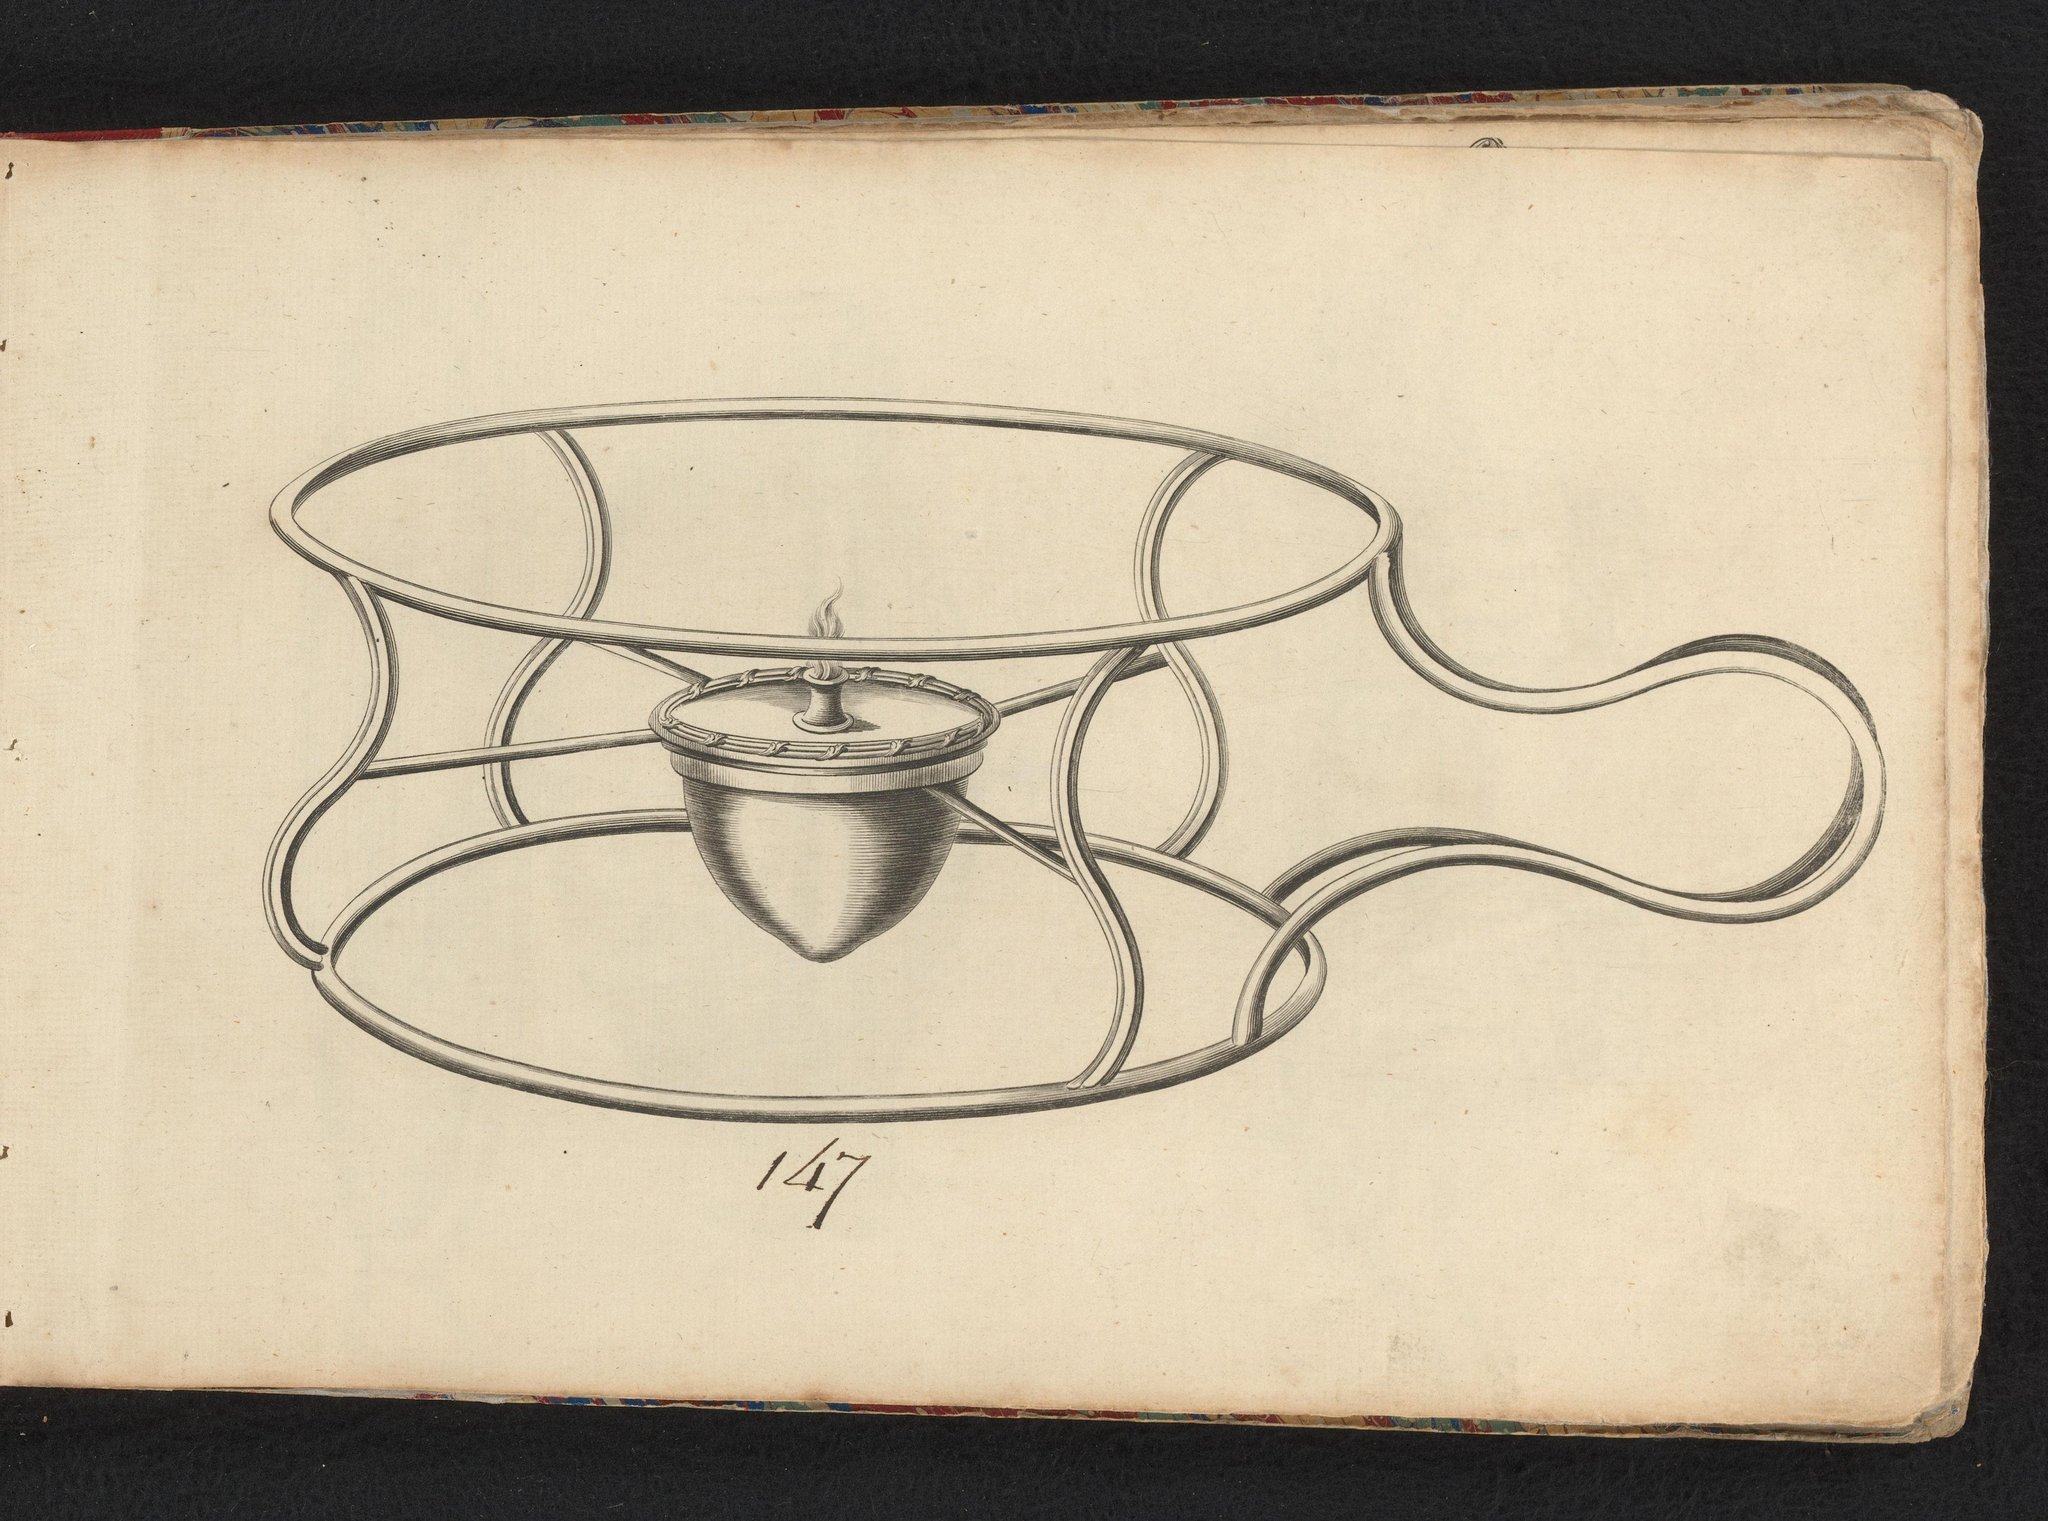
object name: ornament print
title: Ontwerp voor een rechaud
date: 1784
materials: paper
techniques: engraving, etching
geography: england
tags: table-ware, cooking food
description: Ontwerp voor de brander voor een rechaud, op het volle blad. Onderaan handgeschreven nr. 147. Onderdeel van een catalogus met assortiment modellen van Sheffield verzilverd vaatwerk (pleet) door Matthew Boulton.